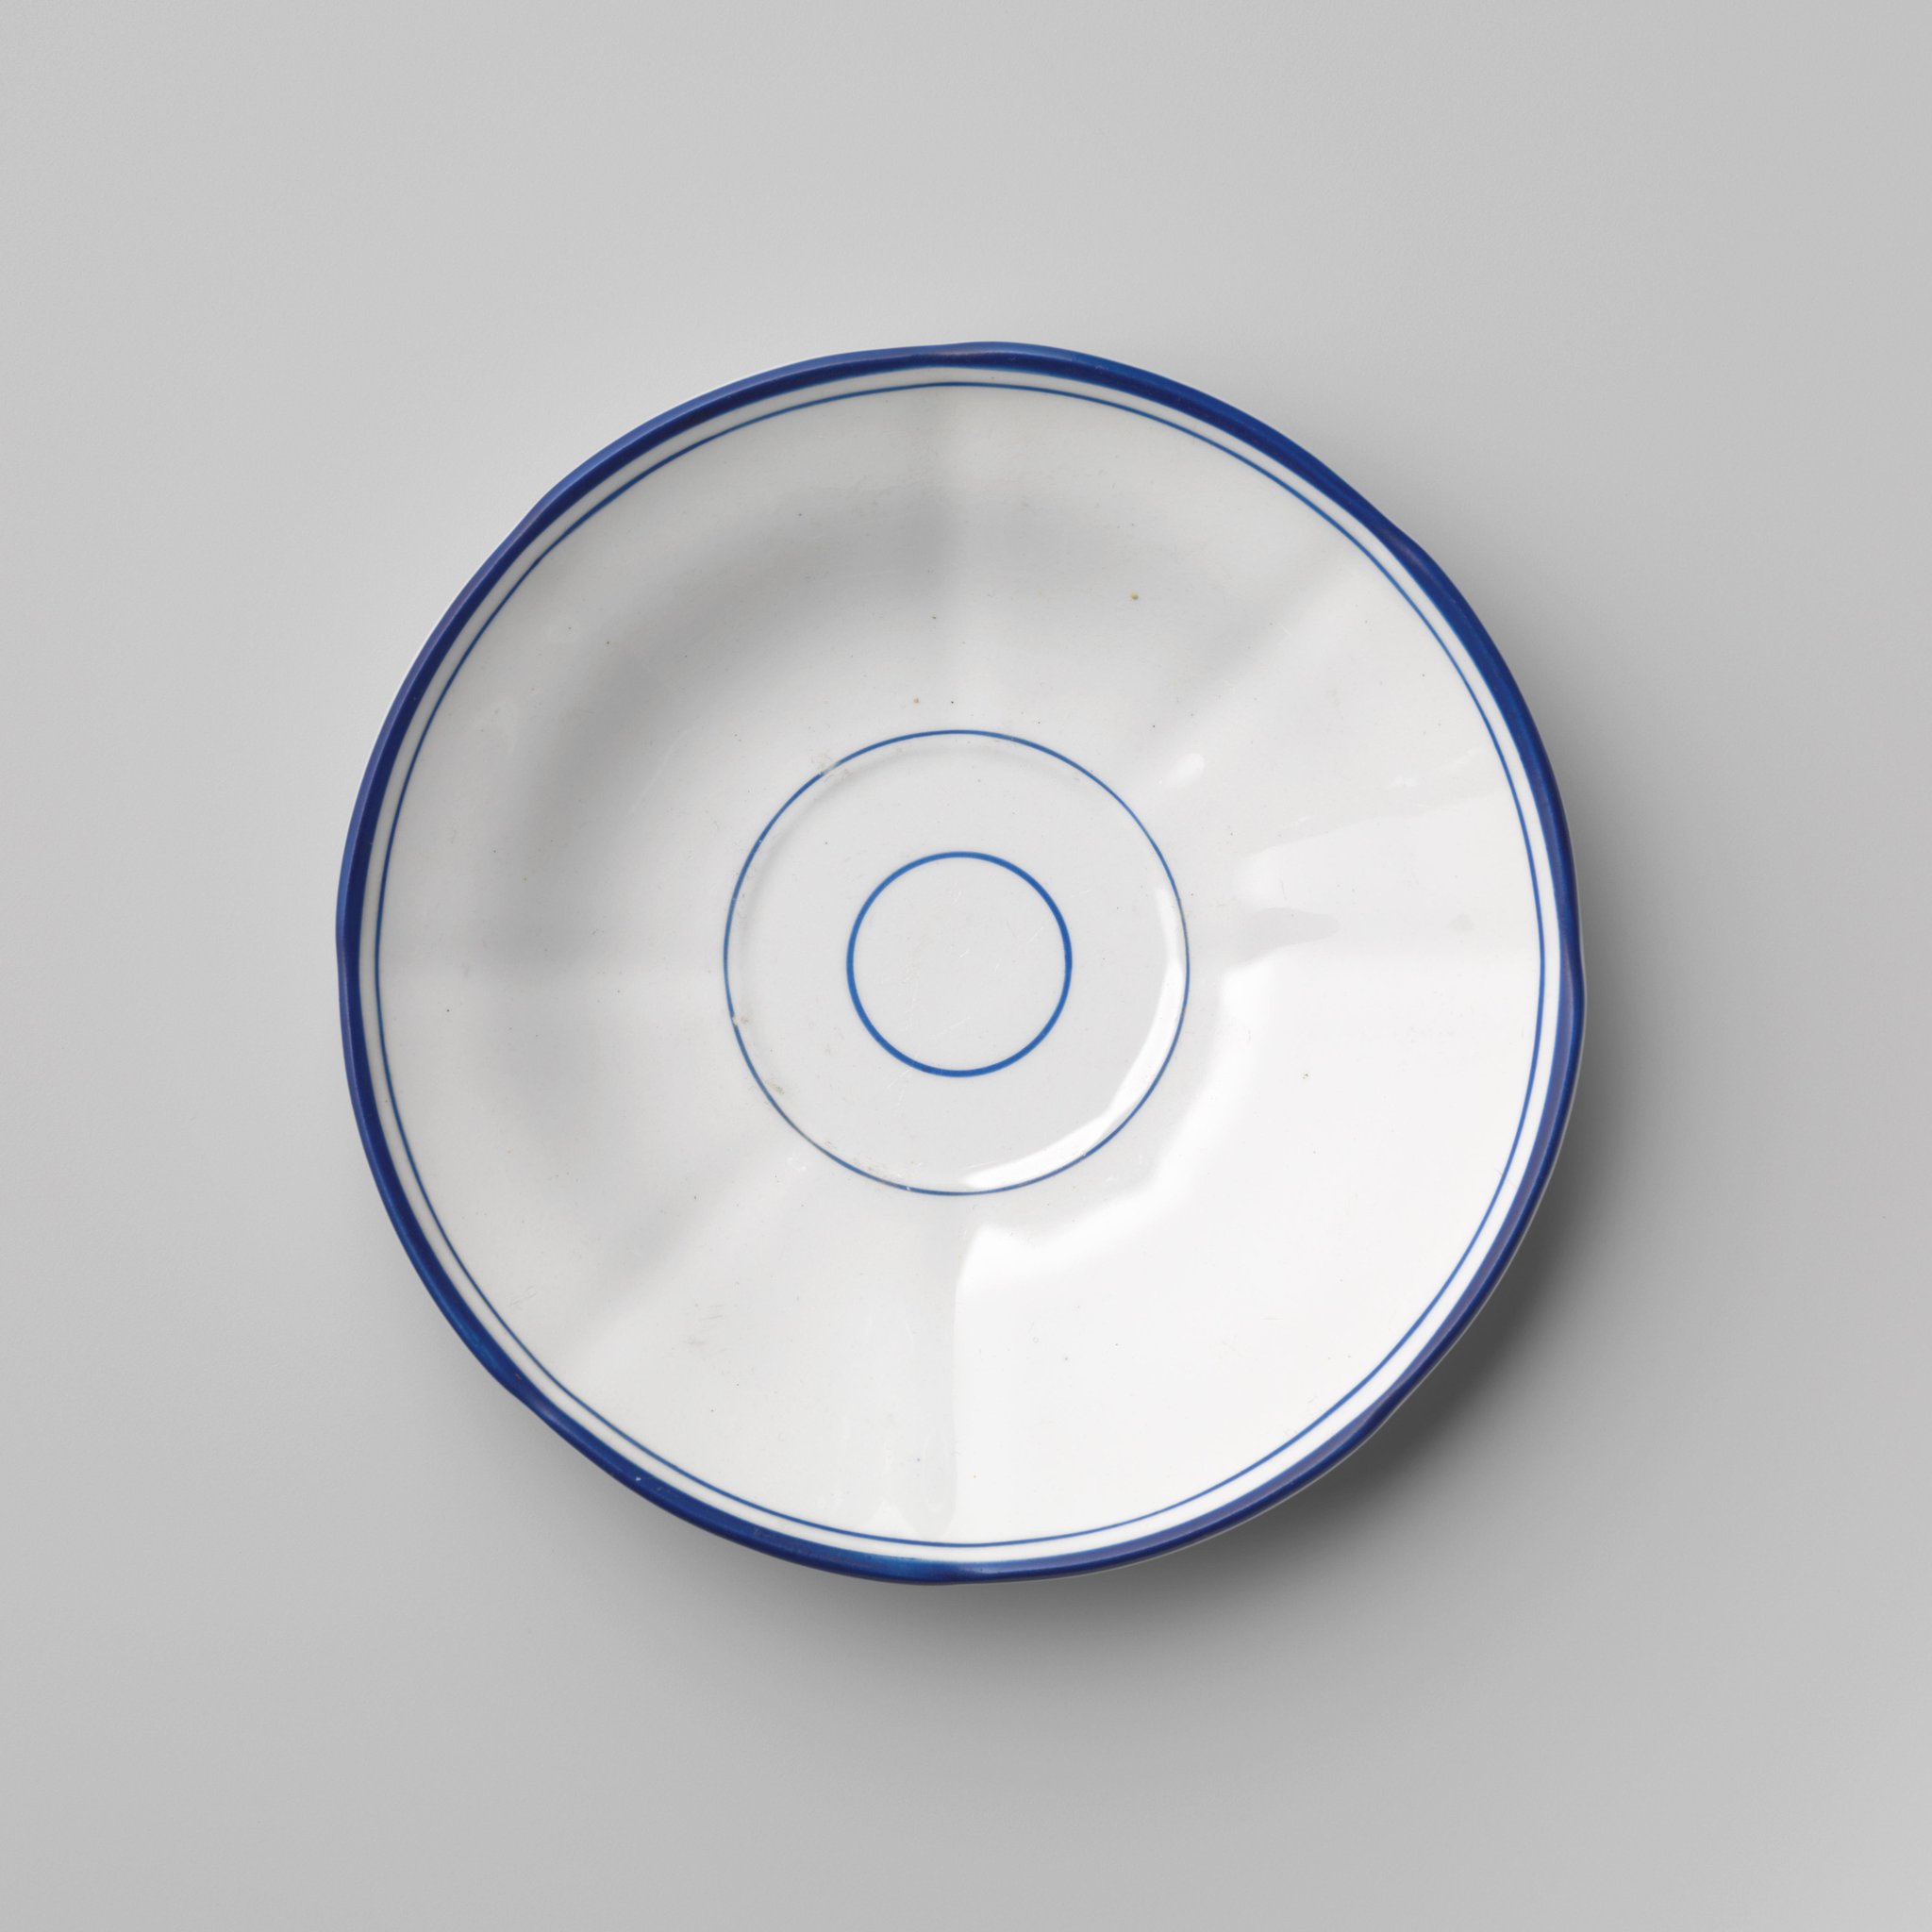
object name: platter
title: Schotel, wit, met blauwe biezen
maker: petrus regout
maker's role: plateelbakker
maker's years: 1801-1879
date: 1860-1890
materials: creamware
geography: maastricht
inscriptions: check stamp: ‘P. REGOUT // MAASTRICHT // 10X’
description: Schotel van aardewerk, behorend bij een koffie- en theeservies, wit, met blauwe biezen op het plat en de rand.